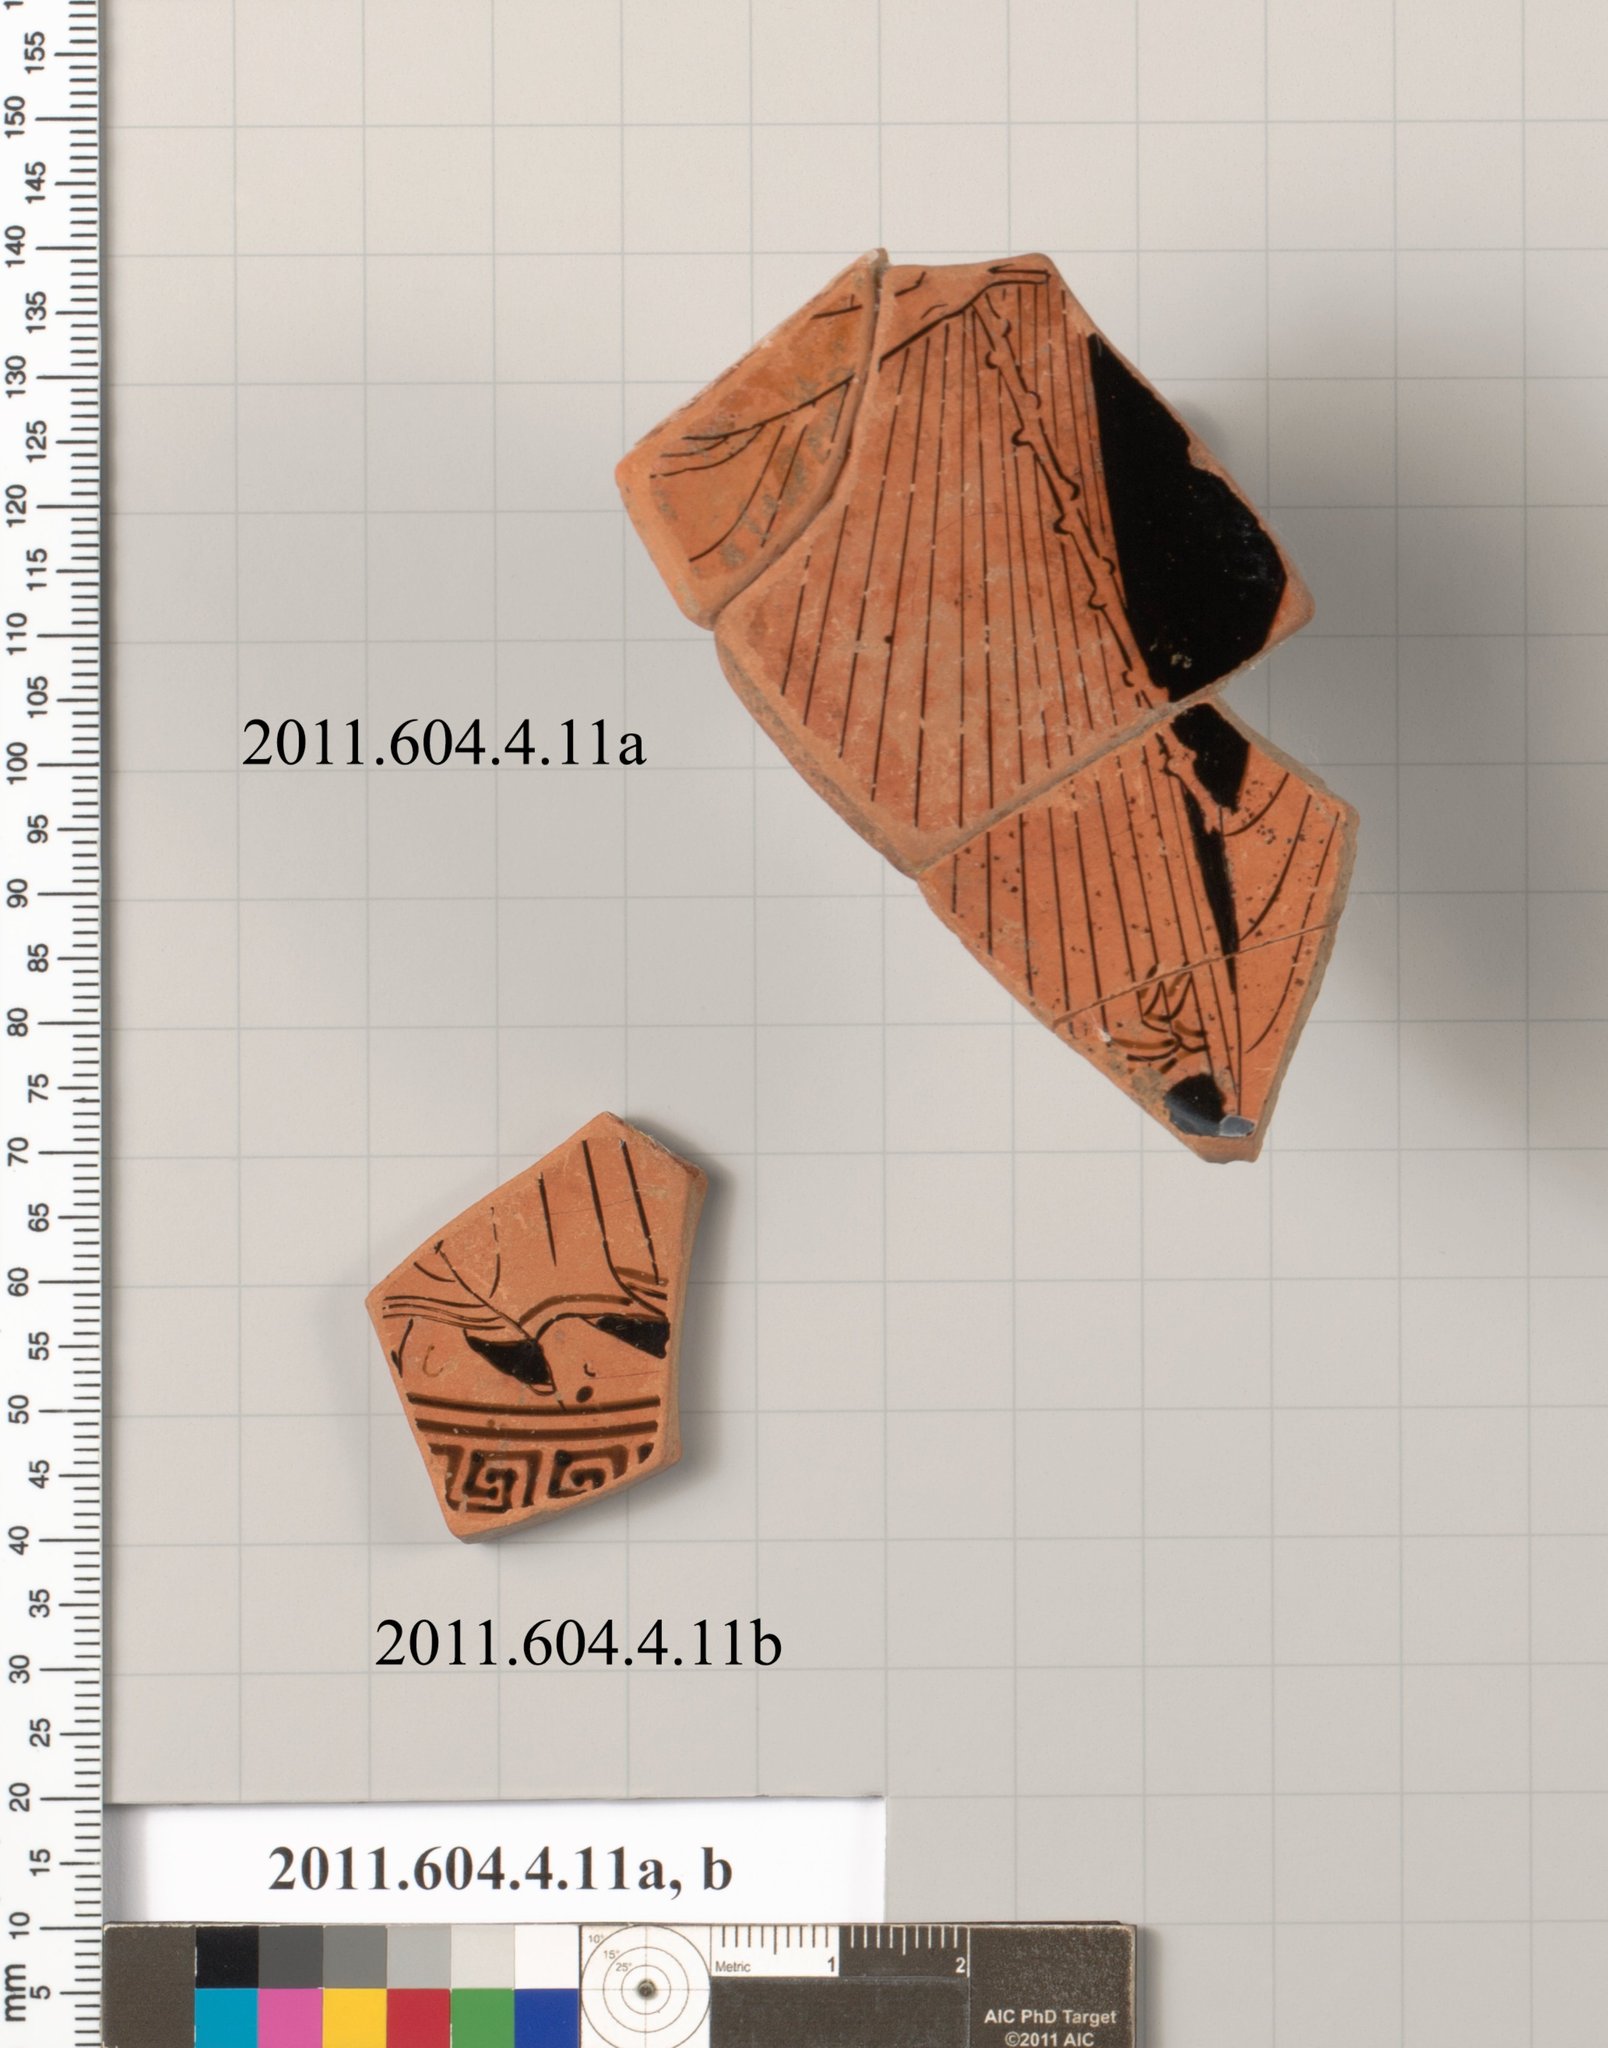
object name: kylix fragment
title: Terracotta fragments of a kylix (drinking cup)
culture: greek, attic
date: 480 BCE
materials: terracotta